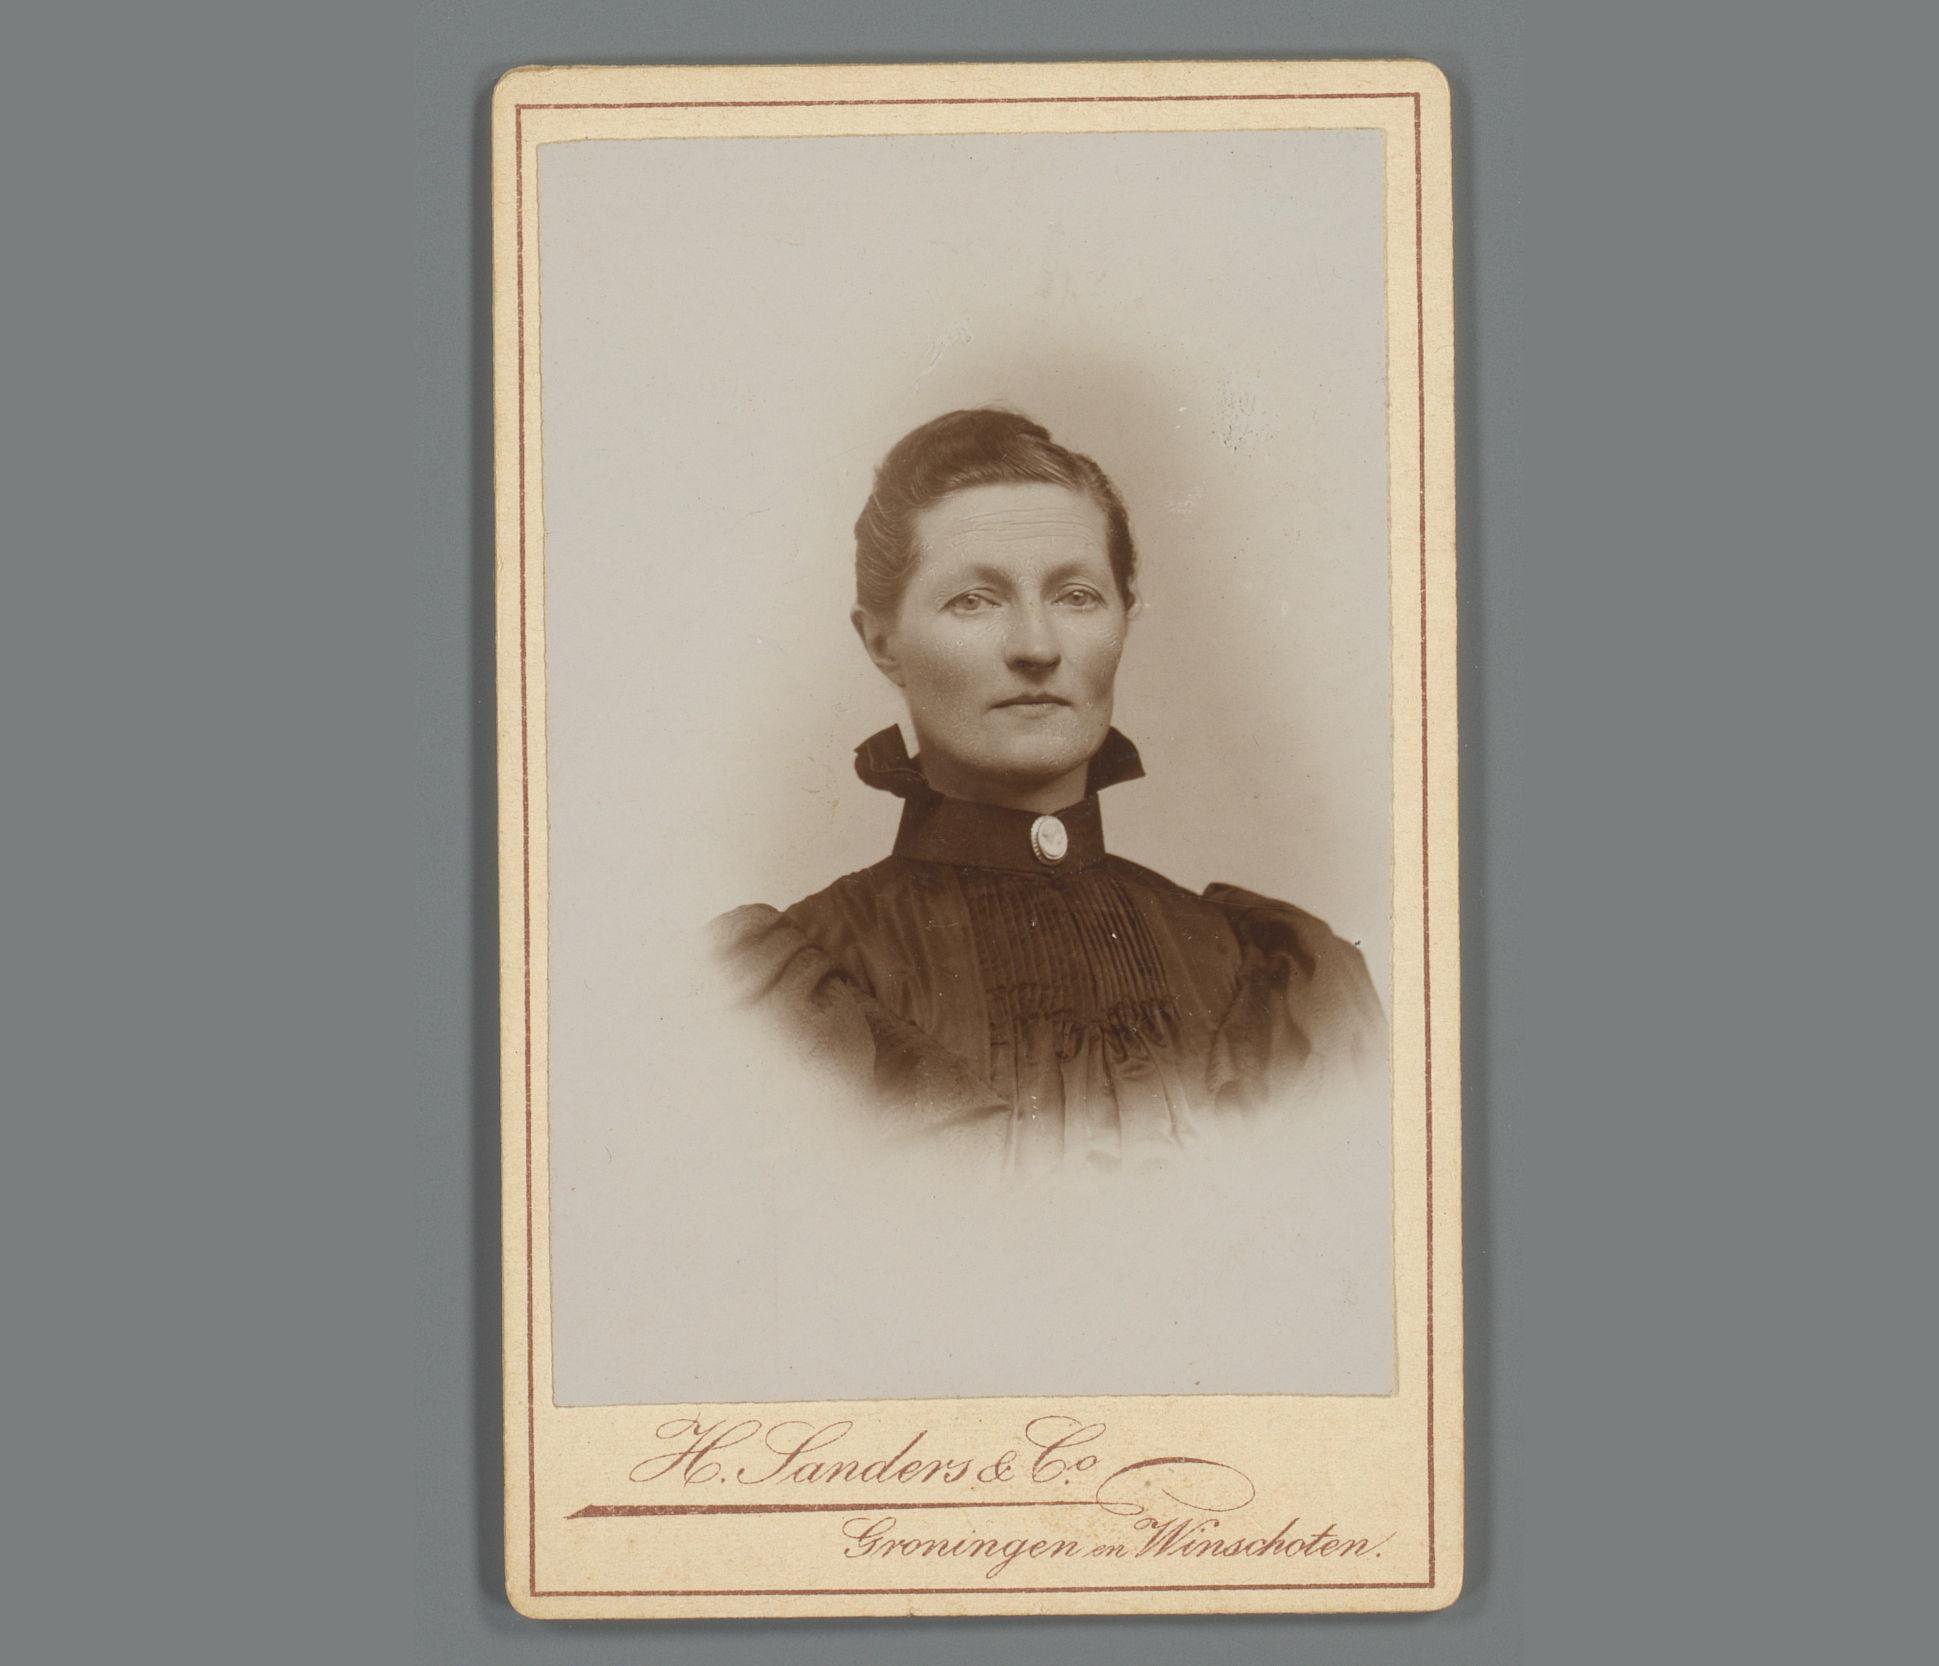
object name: carte de visite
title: Portret van Treintje Meijer-Klugkist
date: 1886-1891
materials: paper, cardboard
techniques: collodion silver print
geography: groningen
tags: historical persons - bb - woman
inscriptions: inscription: ‘H. Sanders & Co./ PHOTOGRAPHEN/ GRONINGEN/ Nieuwe Ebbingestraat 47./ Folkingestraat 295a/ en WINSCHOTEN/ Visschersdijk./ Deze Plaat blijft ter nabestelling bewaard./ Inrichting voor Vergrootingen.’, inscription: ‘Treintje Meier Klugkist’